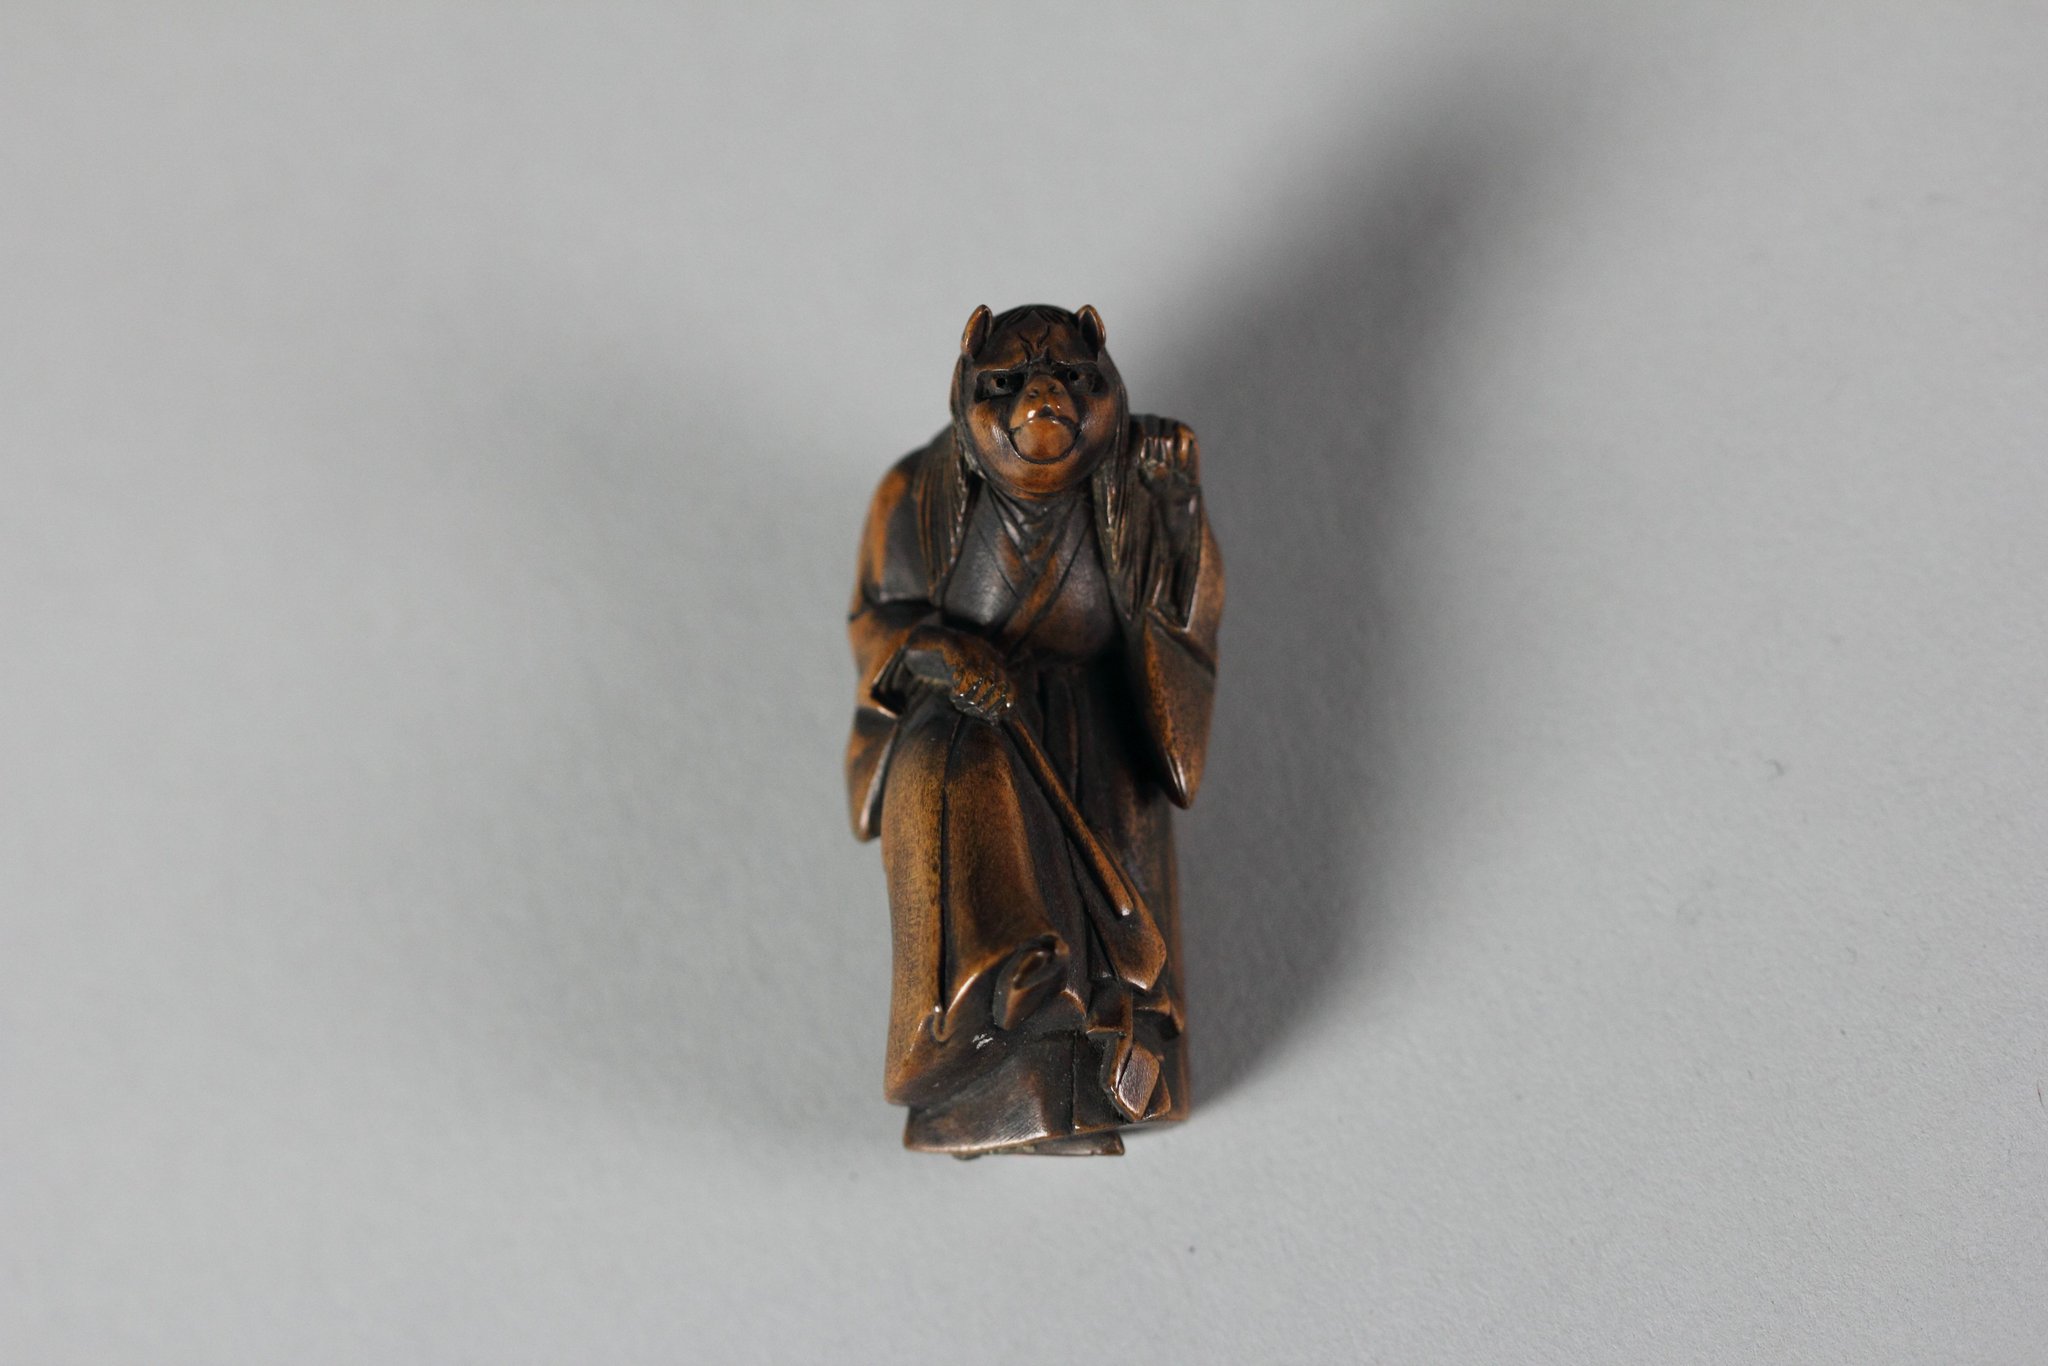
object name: netsuke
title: Netsuke of Masked Figure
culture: japanese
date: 1701-1800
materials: wood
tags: human figures